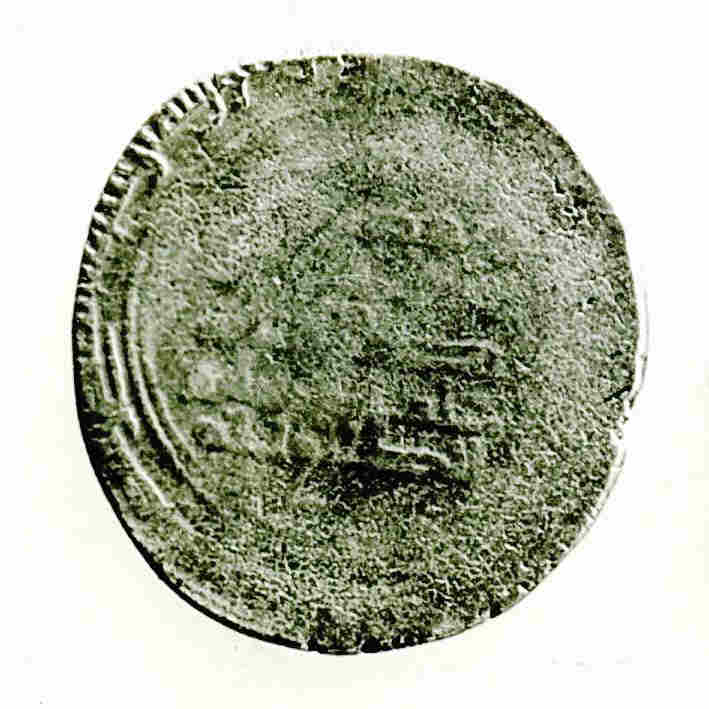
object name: coin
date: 977-982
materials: silver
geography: iran